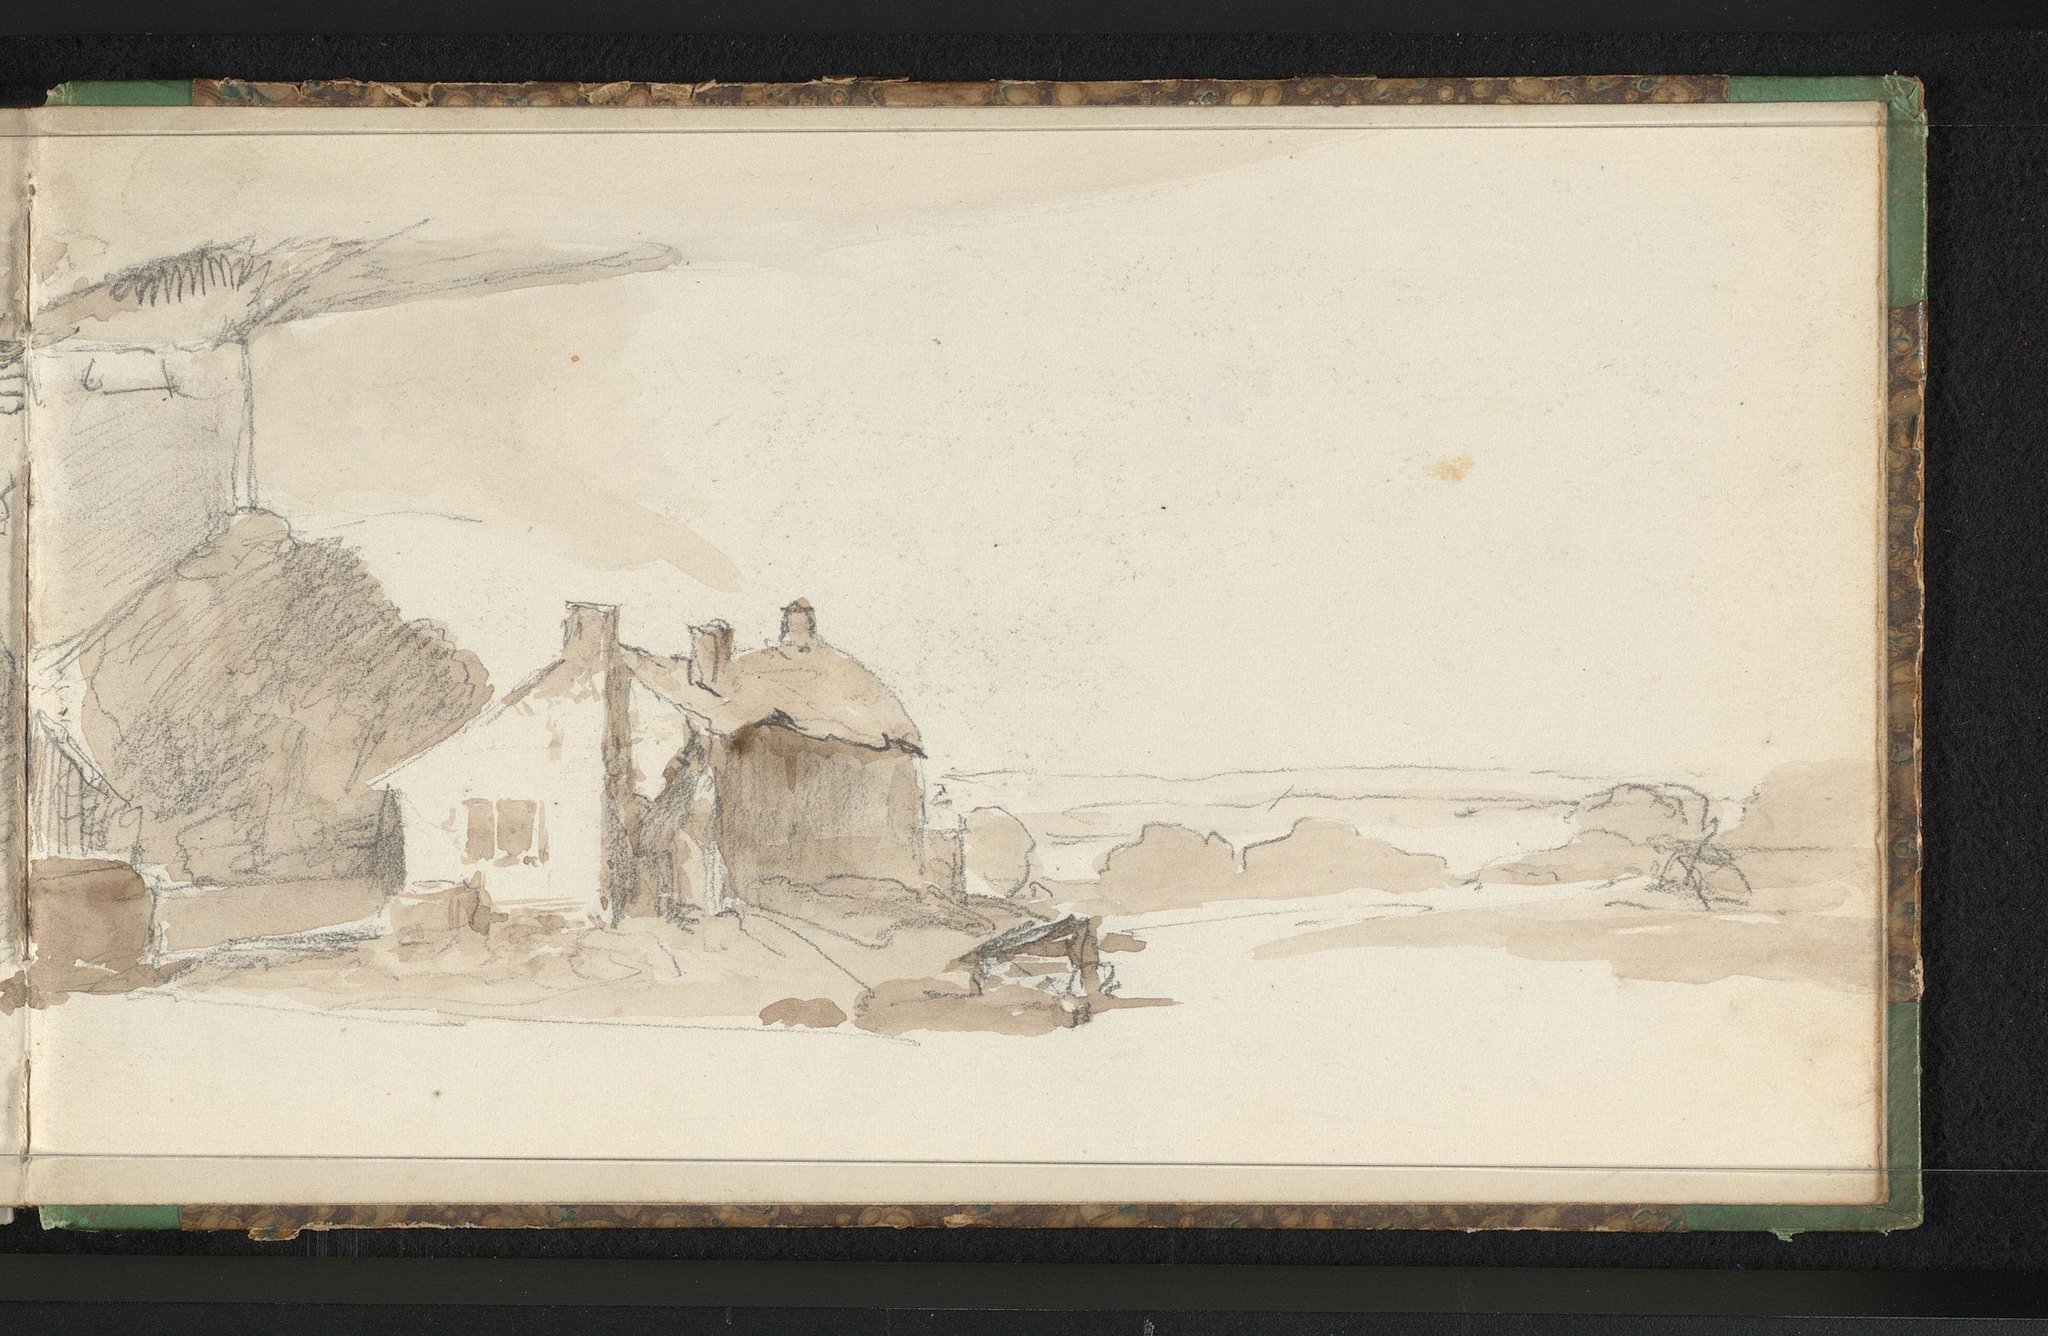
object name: sketchbook leaf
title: Landschap met bebouwing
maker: jan bedijs tom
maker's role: draughtsman, painter, print maker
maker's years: 1813-1894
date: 1828-1894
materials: paper, pencil, watercolor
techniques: brush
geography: the hague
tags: trees, landscapes, artist (in general) making preliminary designs, sketching, farm or solitary house in landscape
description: Pagina 1 verso uit een schetsboek met 50 bladen.